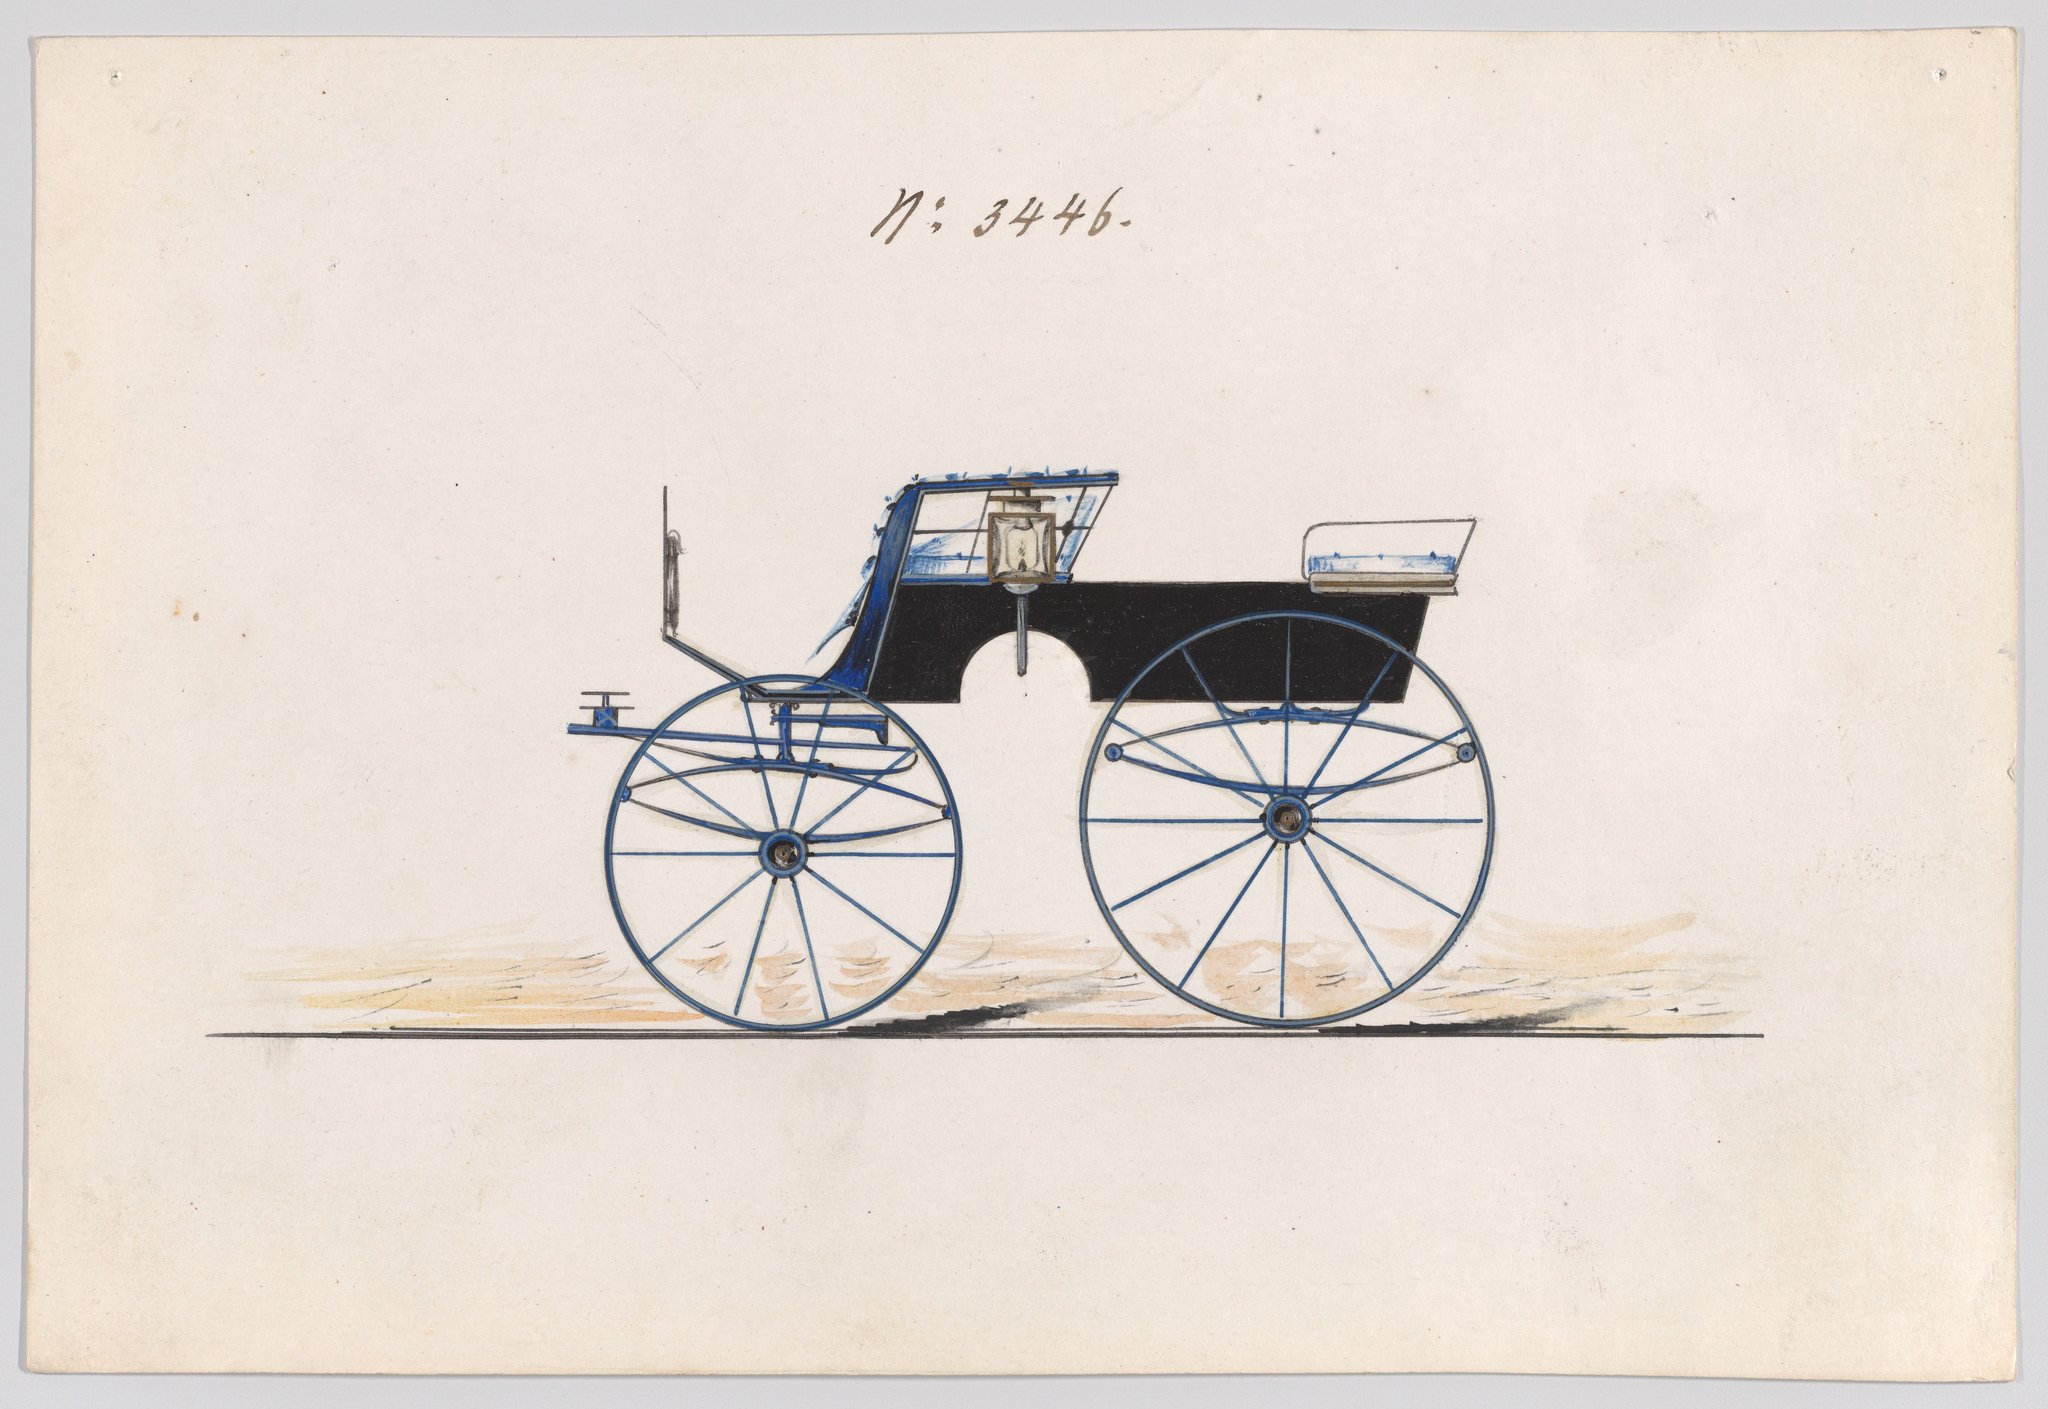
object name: drawing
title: Design for T-Cart, no. 3446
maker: brewster & co.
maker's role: manufacturer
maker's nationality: american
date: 1878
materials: gouache, gum arabic, ink, watercolor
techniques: pen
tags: carriages